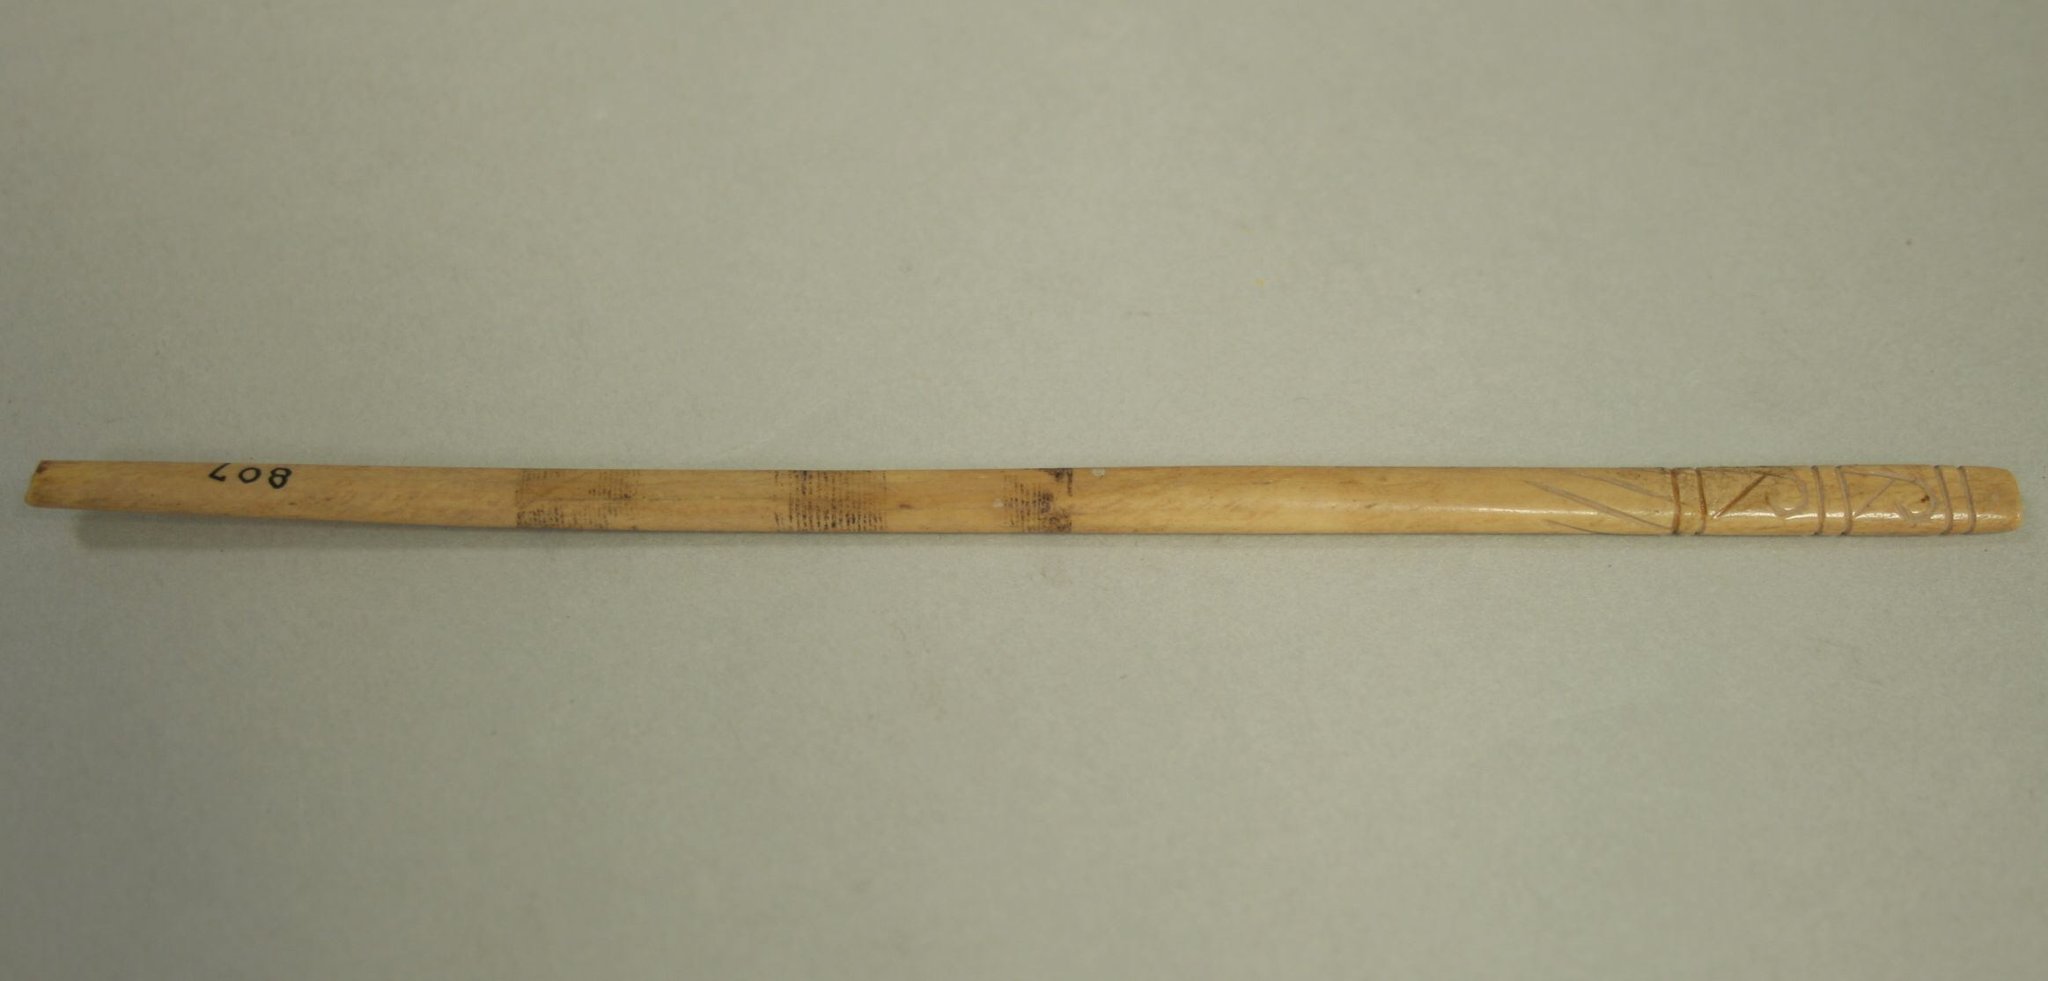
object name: bobbin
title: Bone Weaving Bobbin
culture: peruvian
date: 701-1566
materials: bone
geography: peru